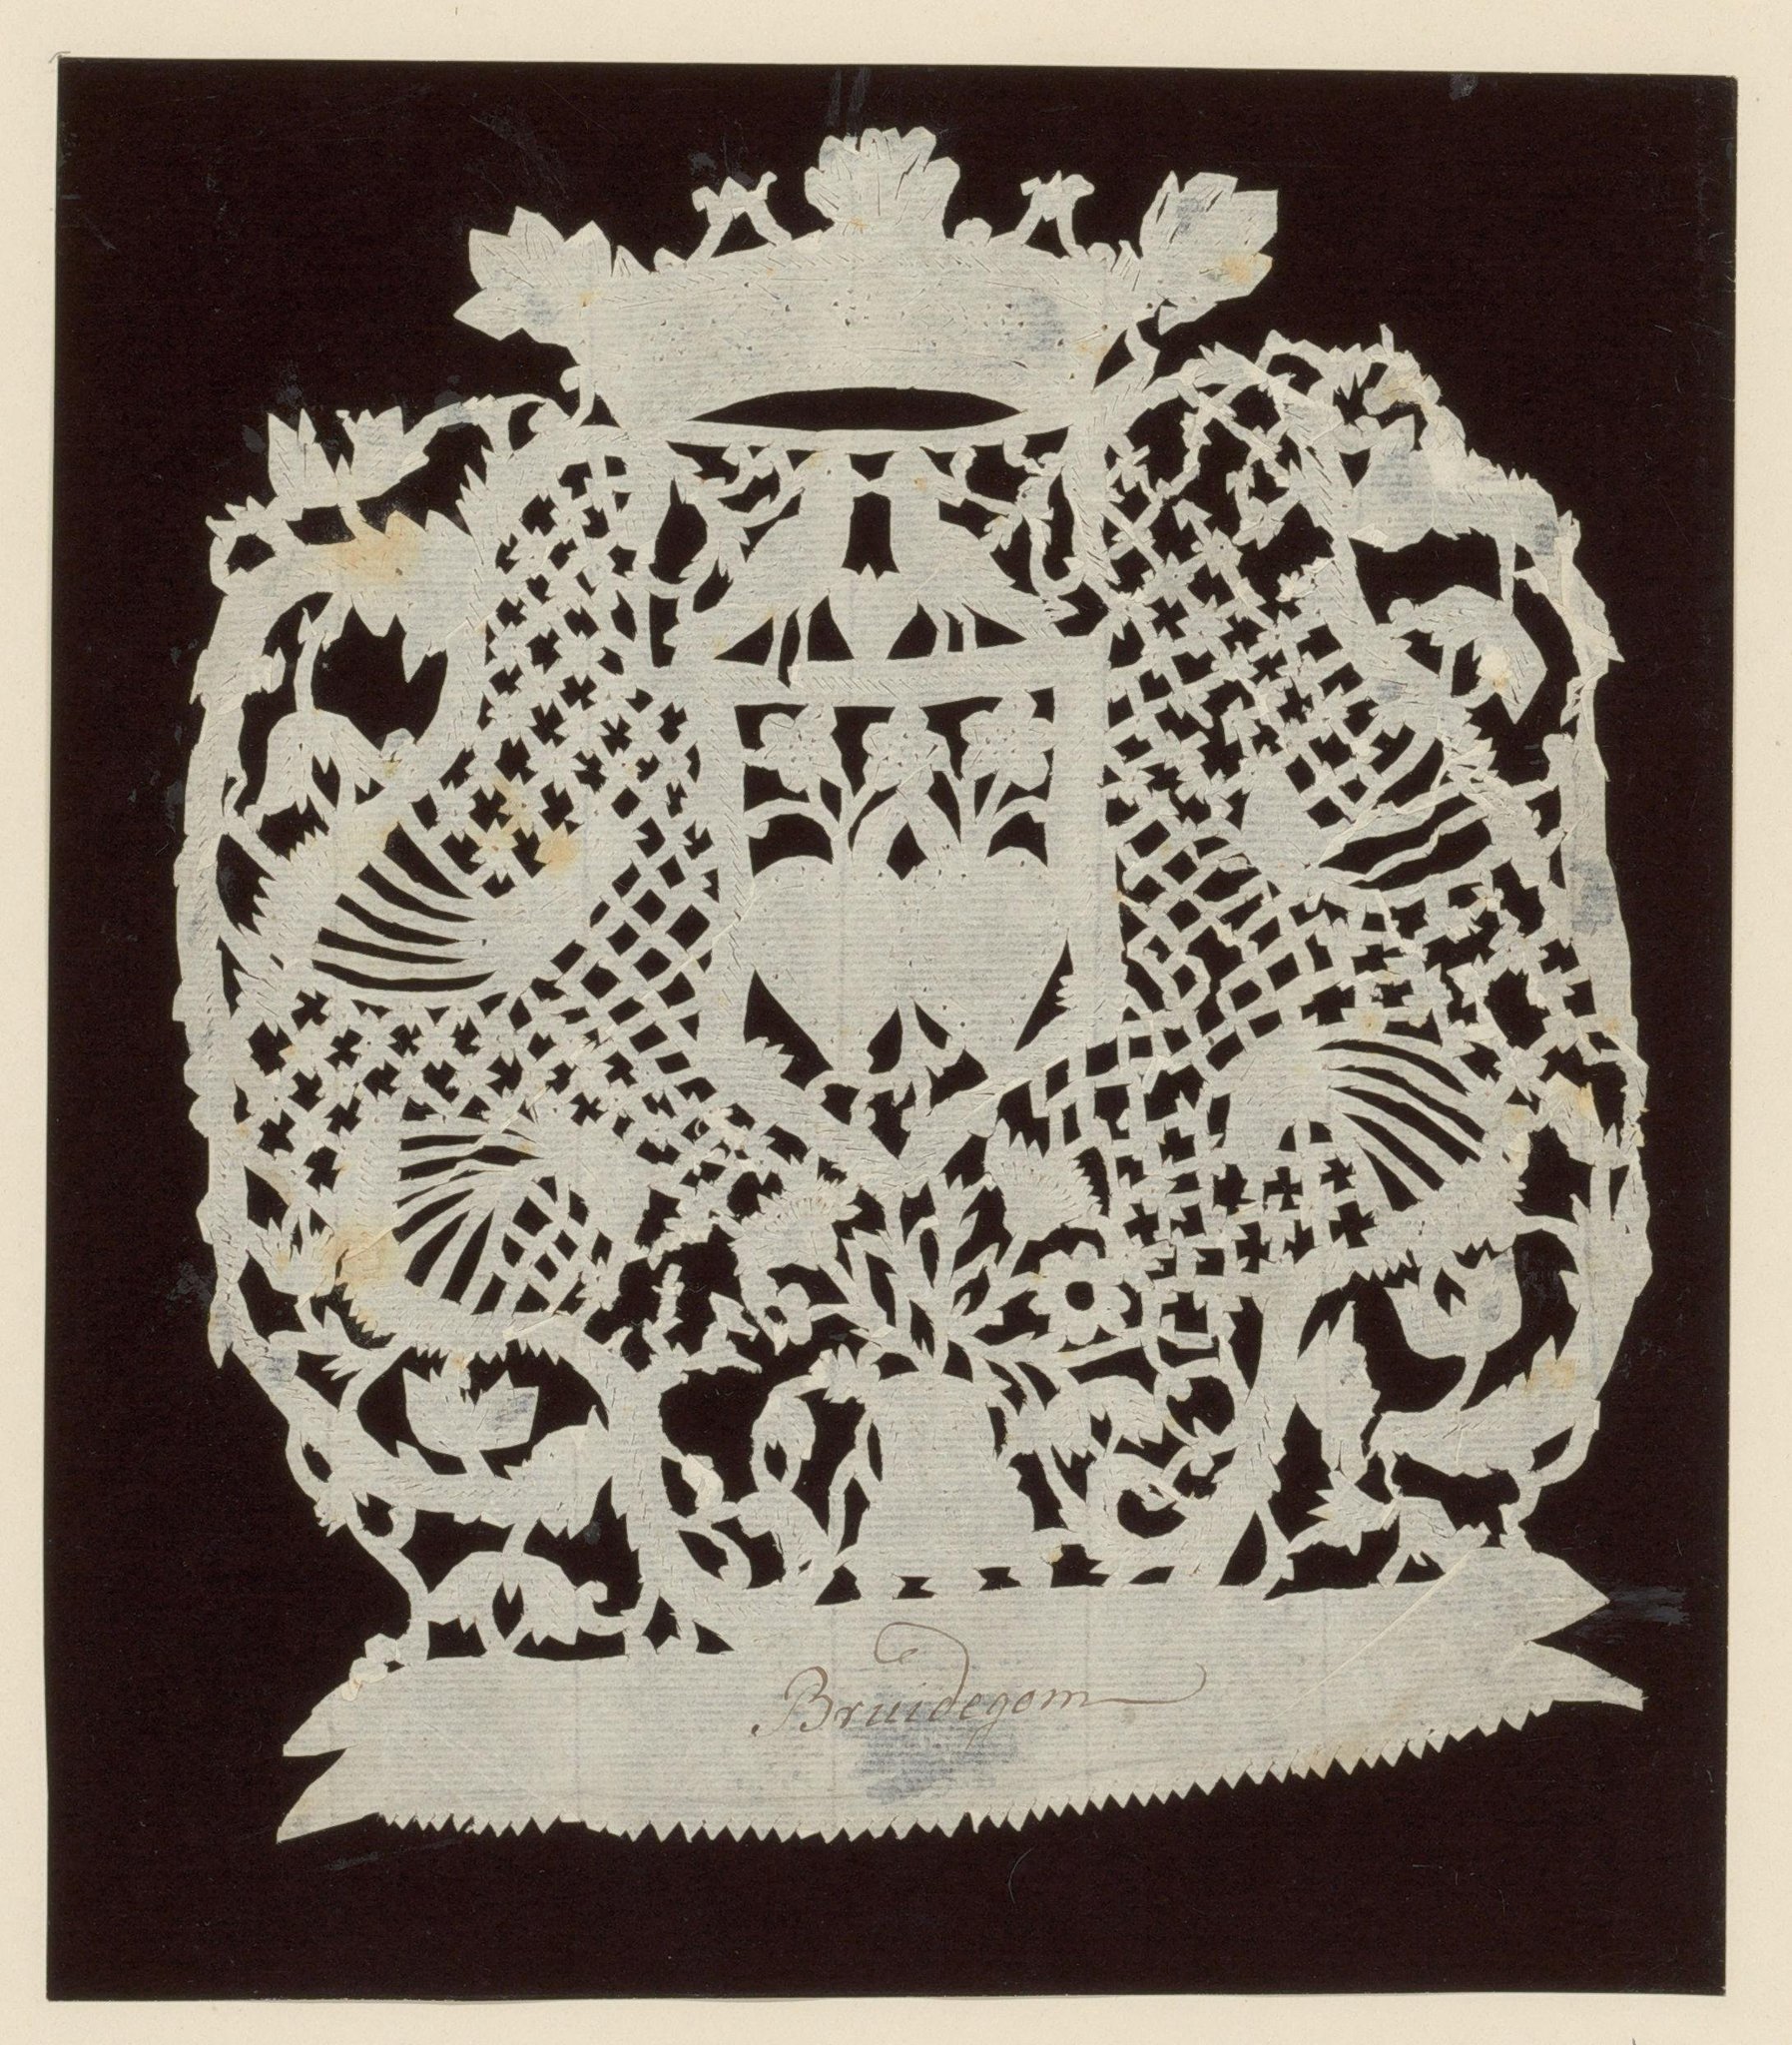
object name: cut paper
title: Huwelijksknipsel met harten en dieren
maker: Anonymous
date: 1750-1849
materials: ink, paper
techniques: pen, snipping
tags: flowers, marriage, married couple, 'matrimonium'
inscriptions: stamp, collector's mark: Lugt 1641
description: Plaatsaanduiding voor huwelijksmaaltijd met harten en dieren. In het midden twee harten met bloemen. Daarboven twee duiven aan weerszijden van een hart. Daaromheen een rasterwerk en bloemenranken. Het geheel bekroond met een kroon. Onderaan de tekst: Bruidegom. Onderwerpsrubrieken binnen de Atlas Zeden en Gewoonten: Schoone kunsten, Knipkunst.